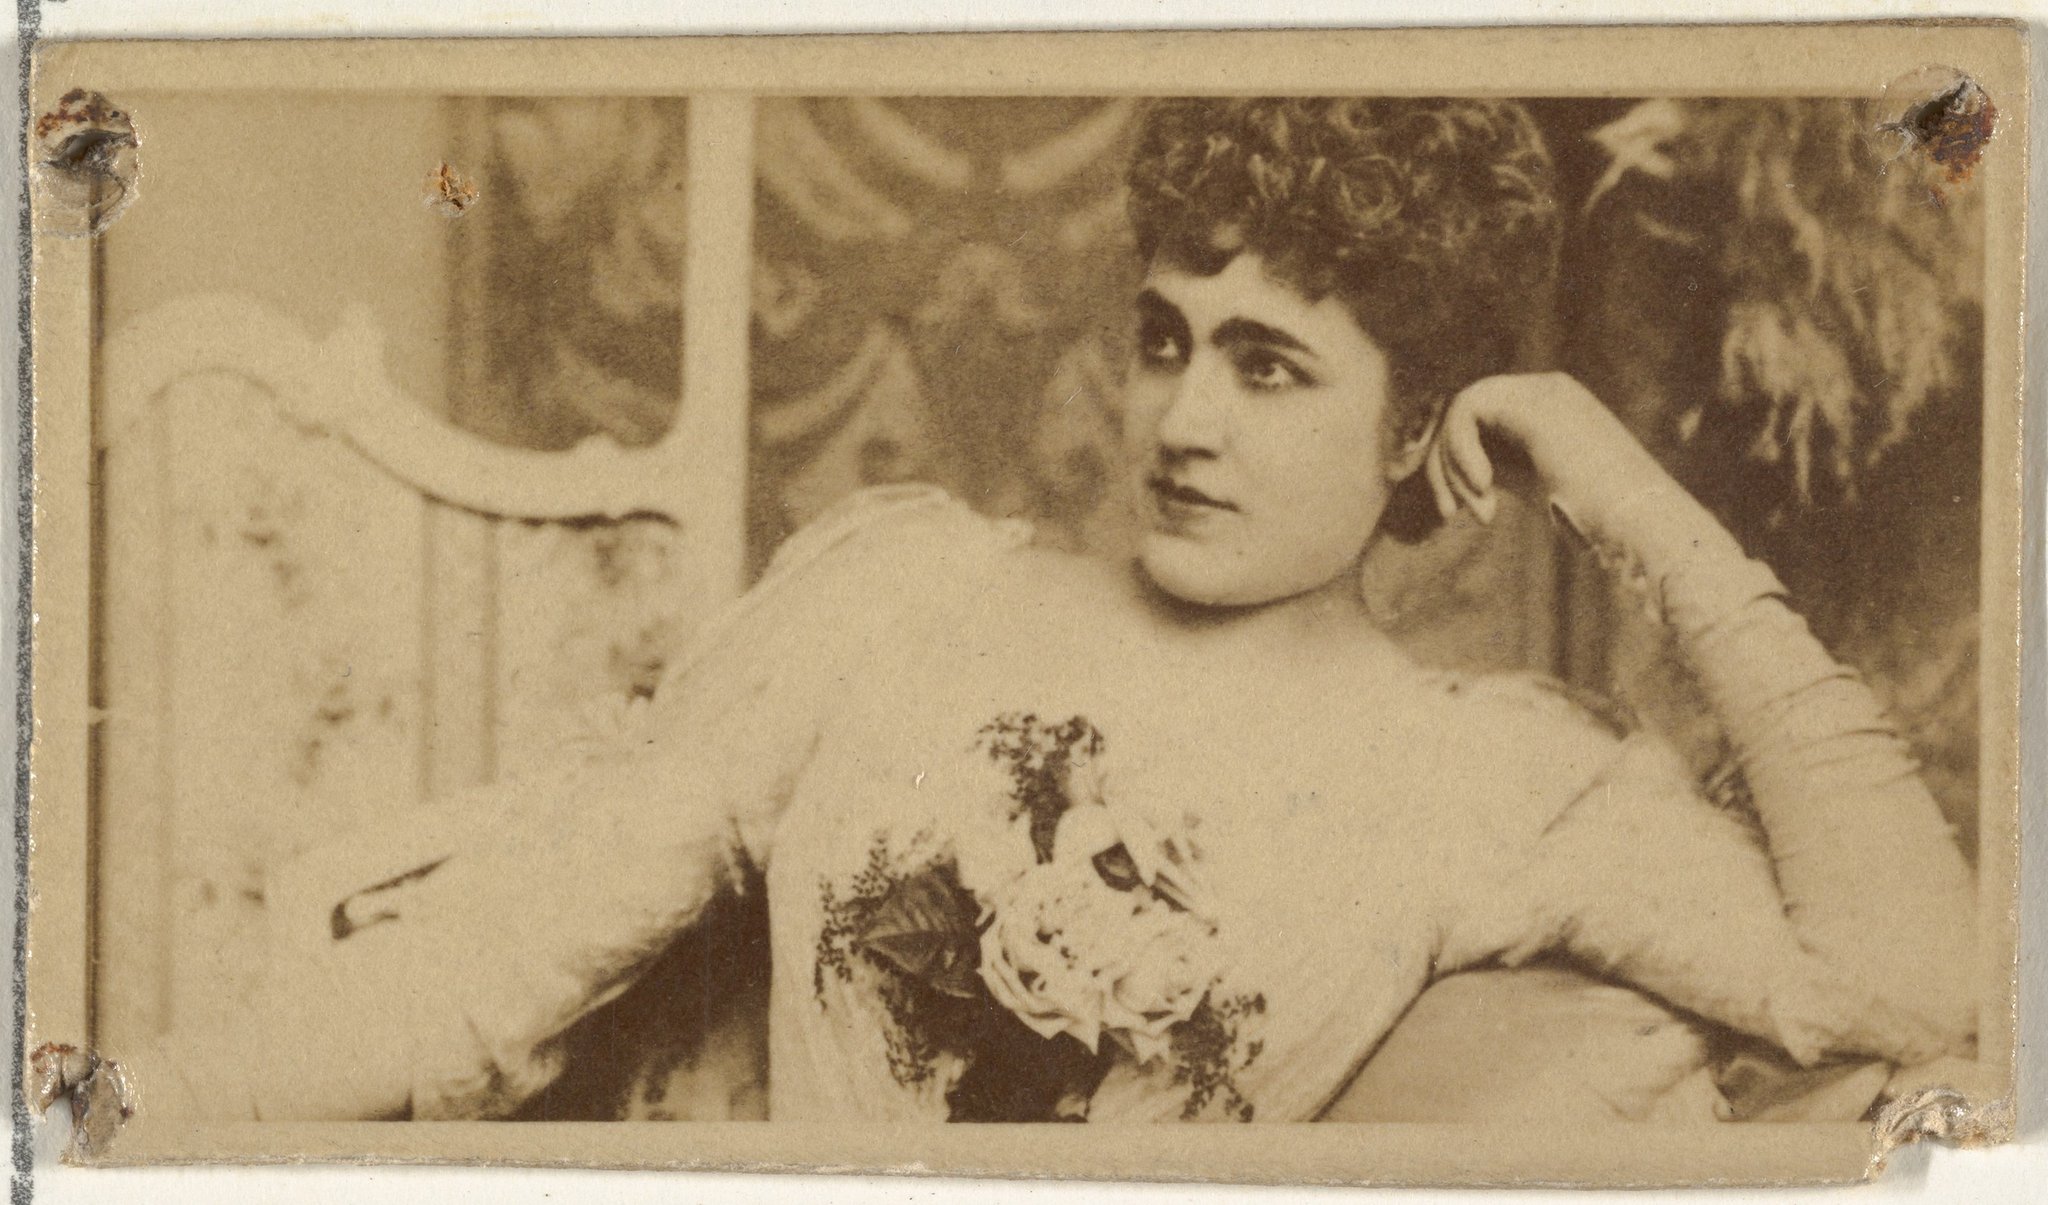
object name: photograph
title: [Actress lounging while holding bouquet of flowers], from the Actors and Actresses series (N145-8) issued by Duke Sons & Co. to promote Duke Cigarettes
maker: w. duke, sons & co.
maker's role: publisher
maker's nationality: american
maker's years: 1870-1920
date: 1891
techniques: albumen silver print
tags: portraits,women,actresses